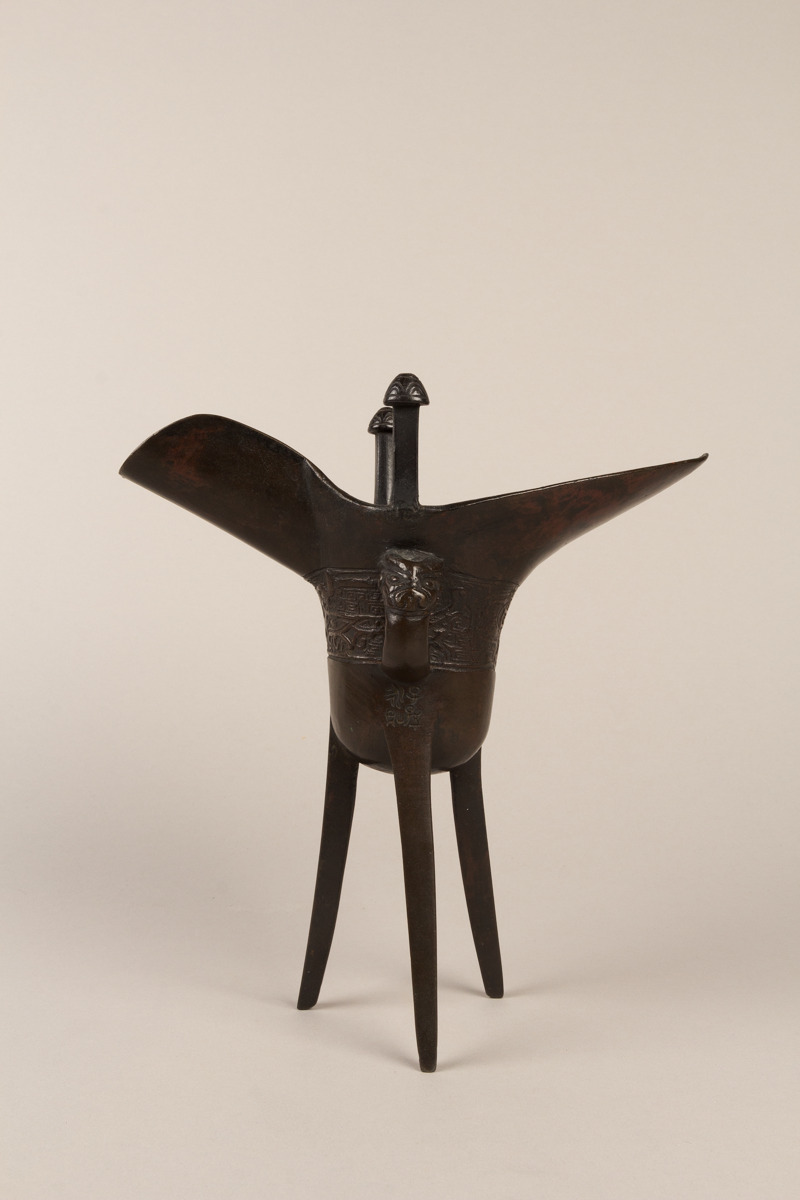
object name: wine warmer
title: Ritual wine warmer (Jue)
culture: chinese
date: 1701-1900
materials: bronze